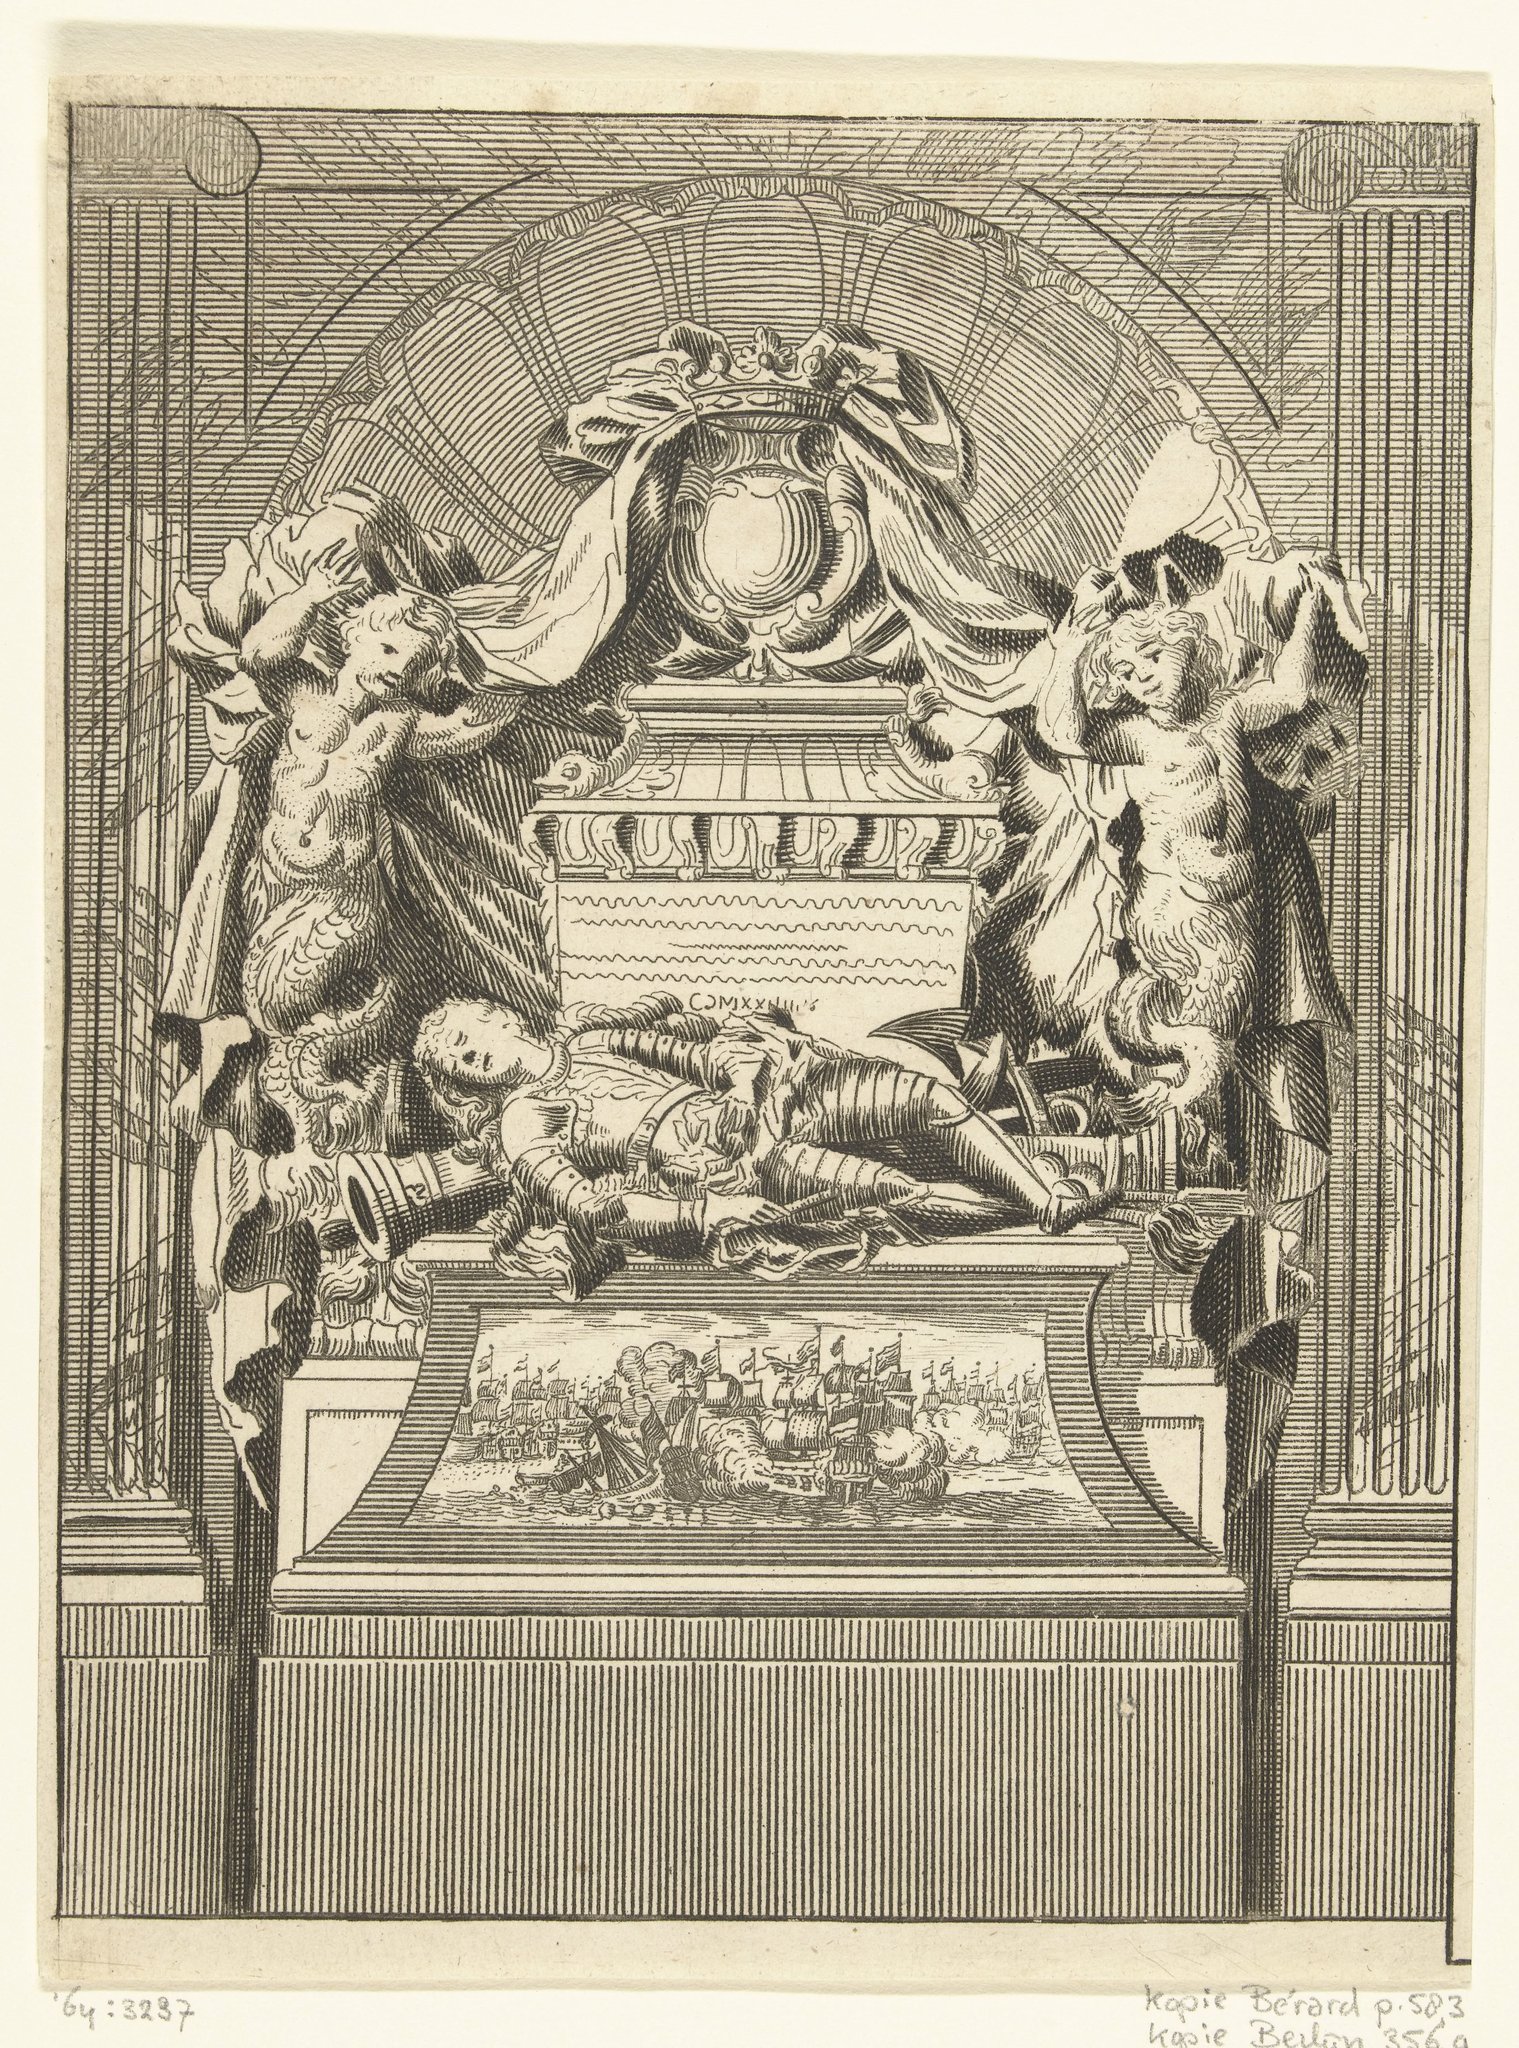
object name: ornament print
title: Epitafenx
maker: Anonymous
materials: paper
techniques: etching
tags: commander-in-chief, admiral (+ naval force)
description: Voor de urn ligt een gezagvoerder ter zee, eronder is een bas-reliëf met een zeeslag te zien.